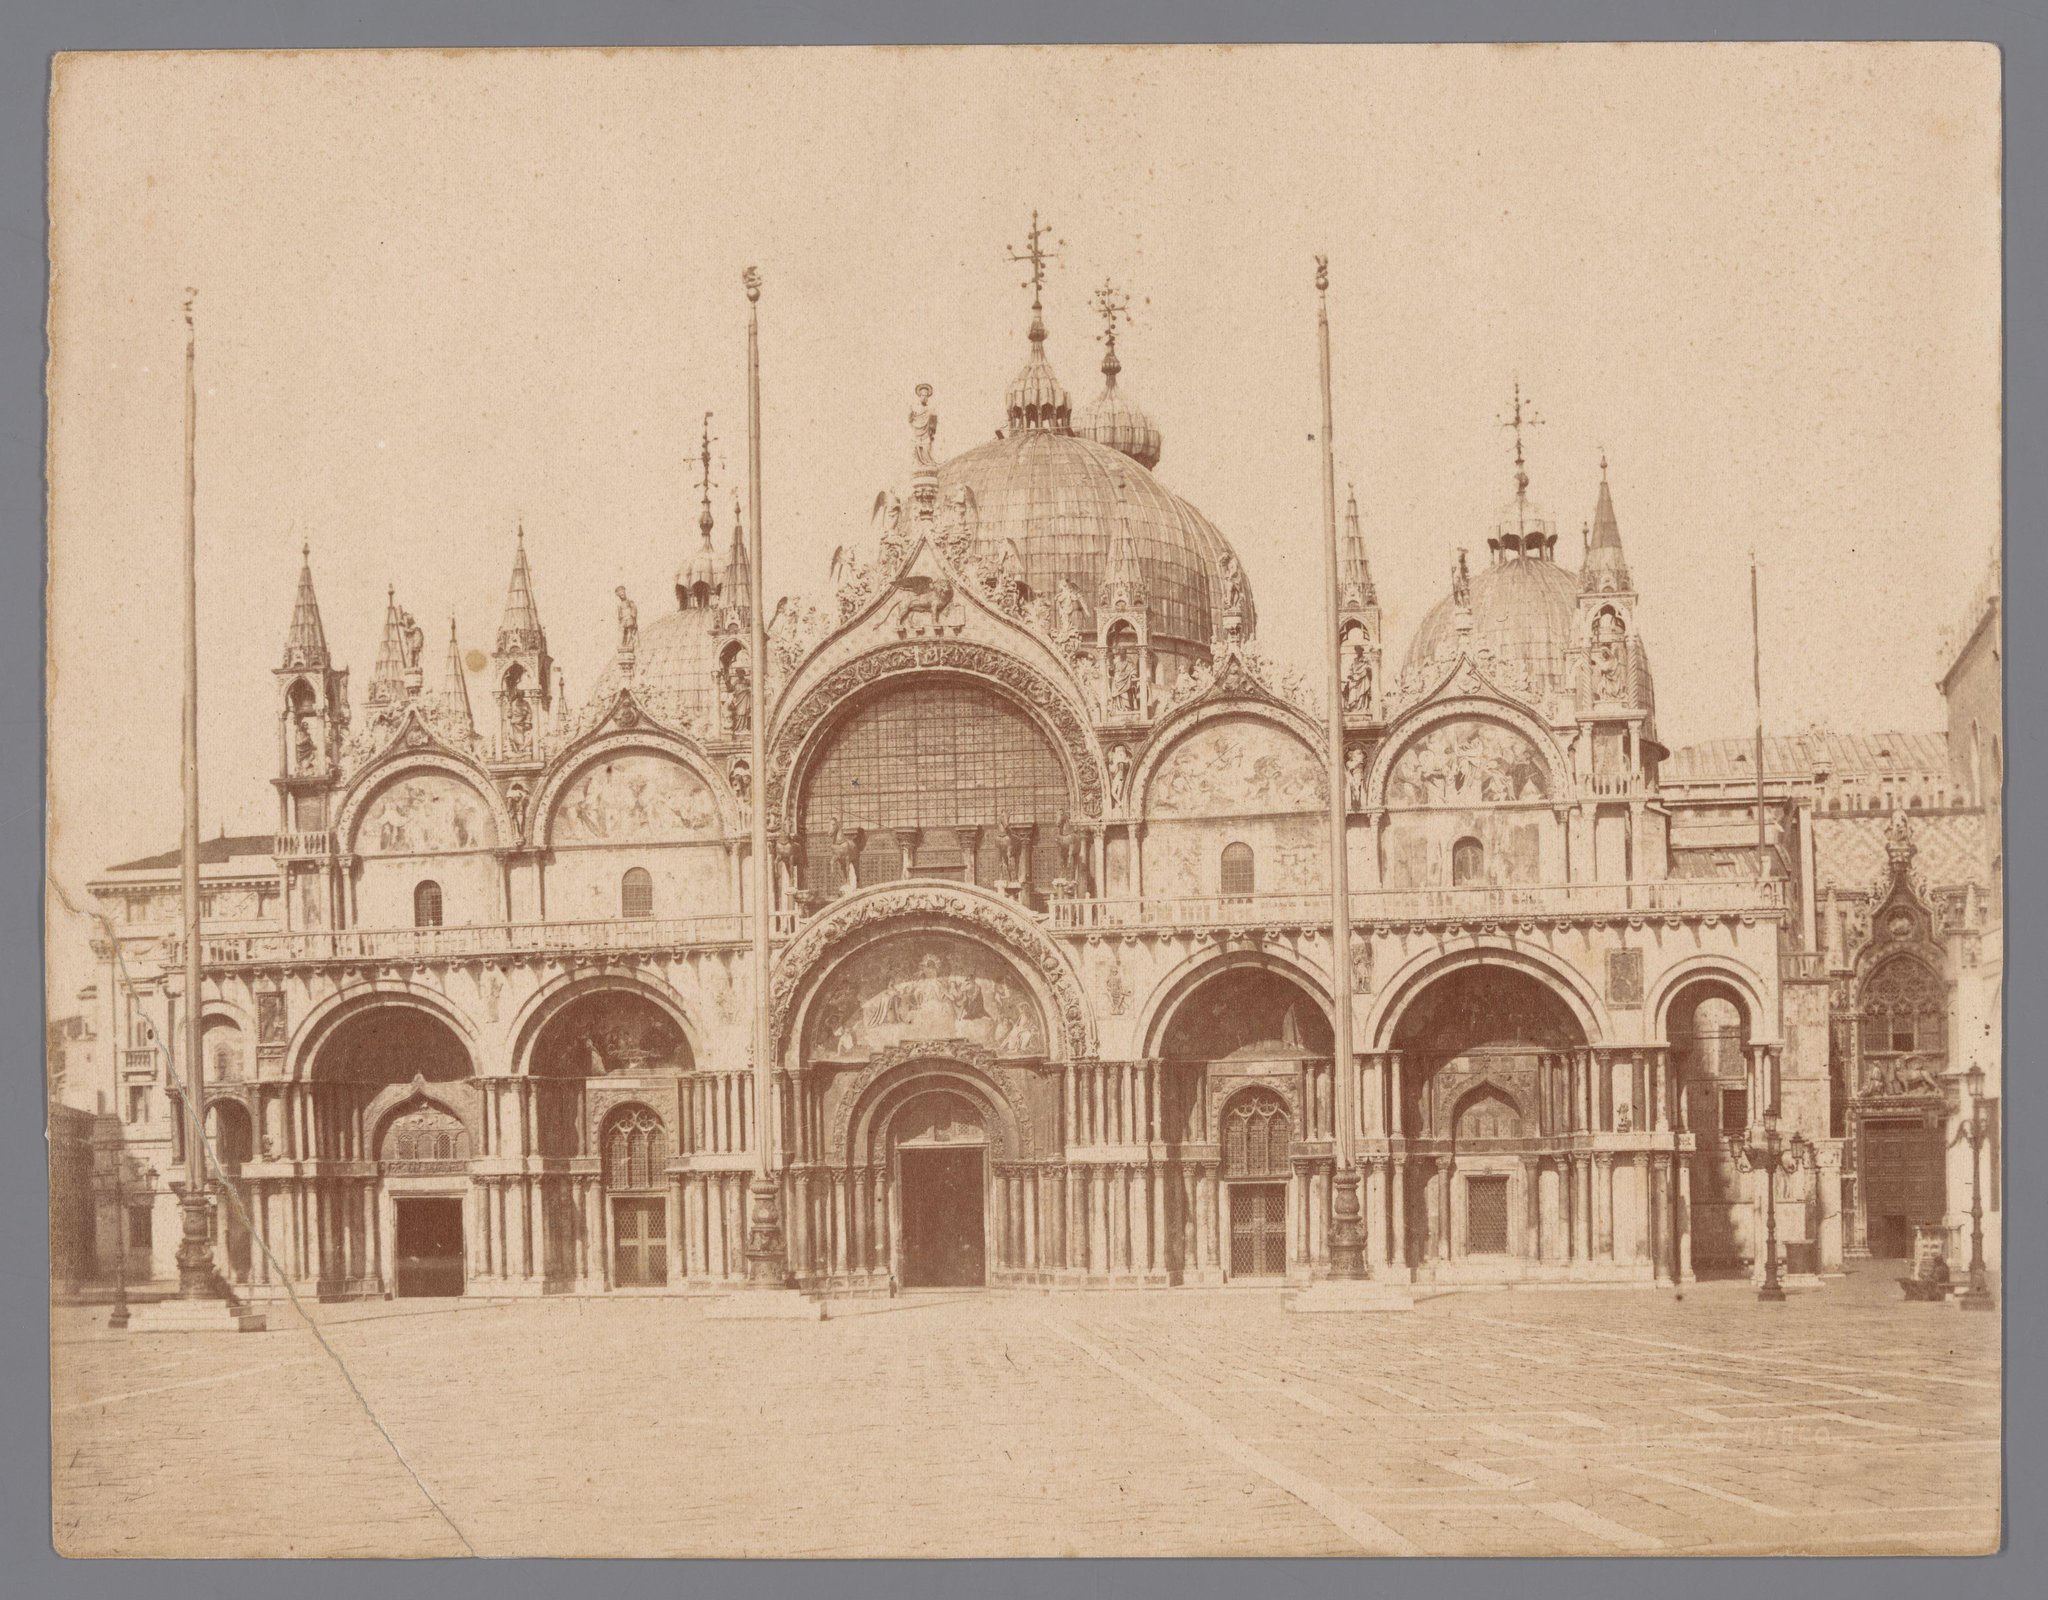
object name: photograph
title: Westgevel van de San Marco te Venetië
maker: Anonymous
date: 1851-1900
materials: paper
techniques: albumen print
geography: venice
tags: parts of church exterior and annexes: west façade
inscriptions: inscription: ‘San Marco, Venetie’